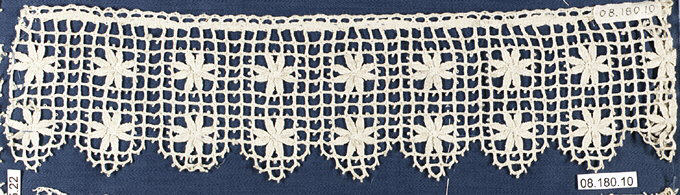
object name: fragment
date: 1801-1900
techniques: lace